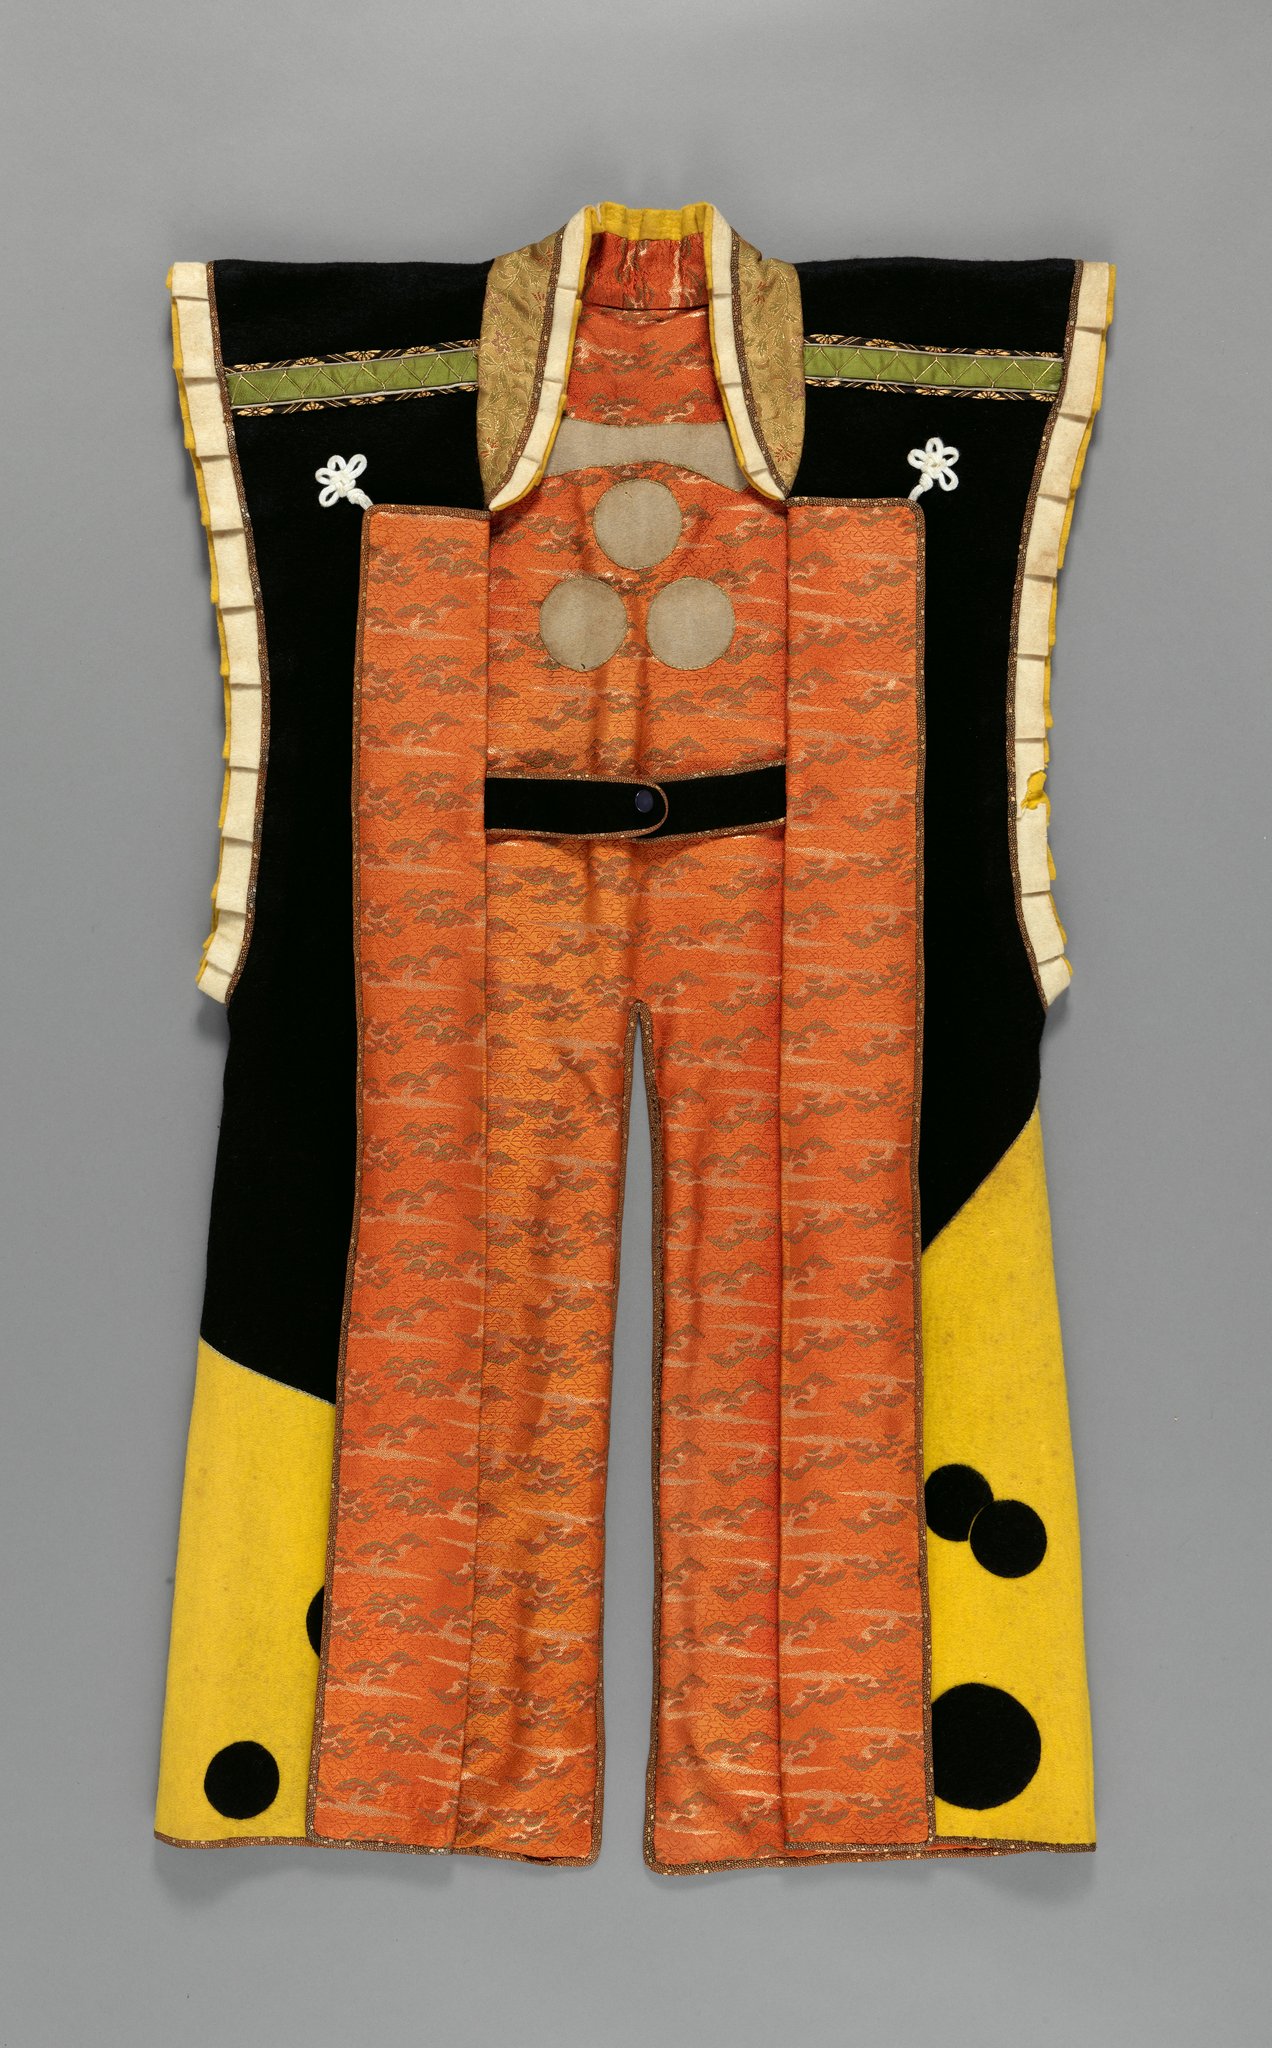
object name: surcoat i jinbaori i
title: Surcoat (Jinbaori)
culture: japanese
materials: silk, wool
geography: japan